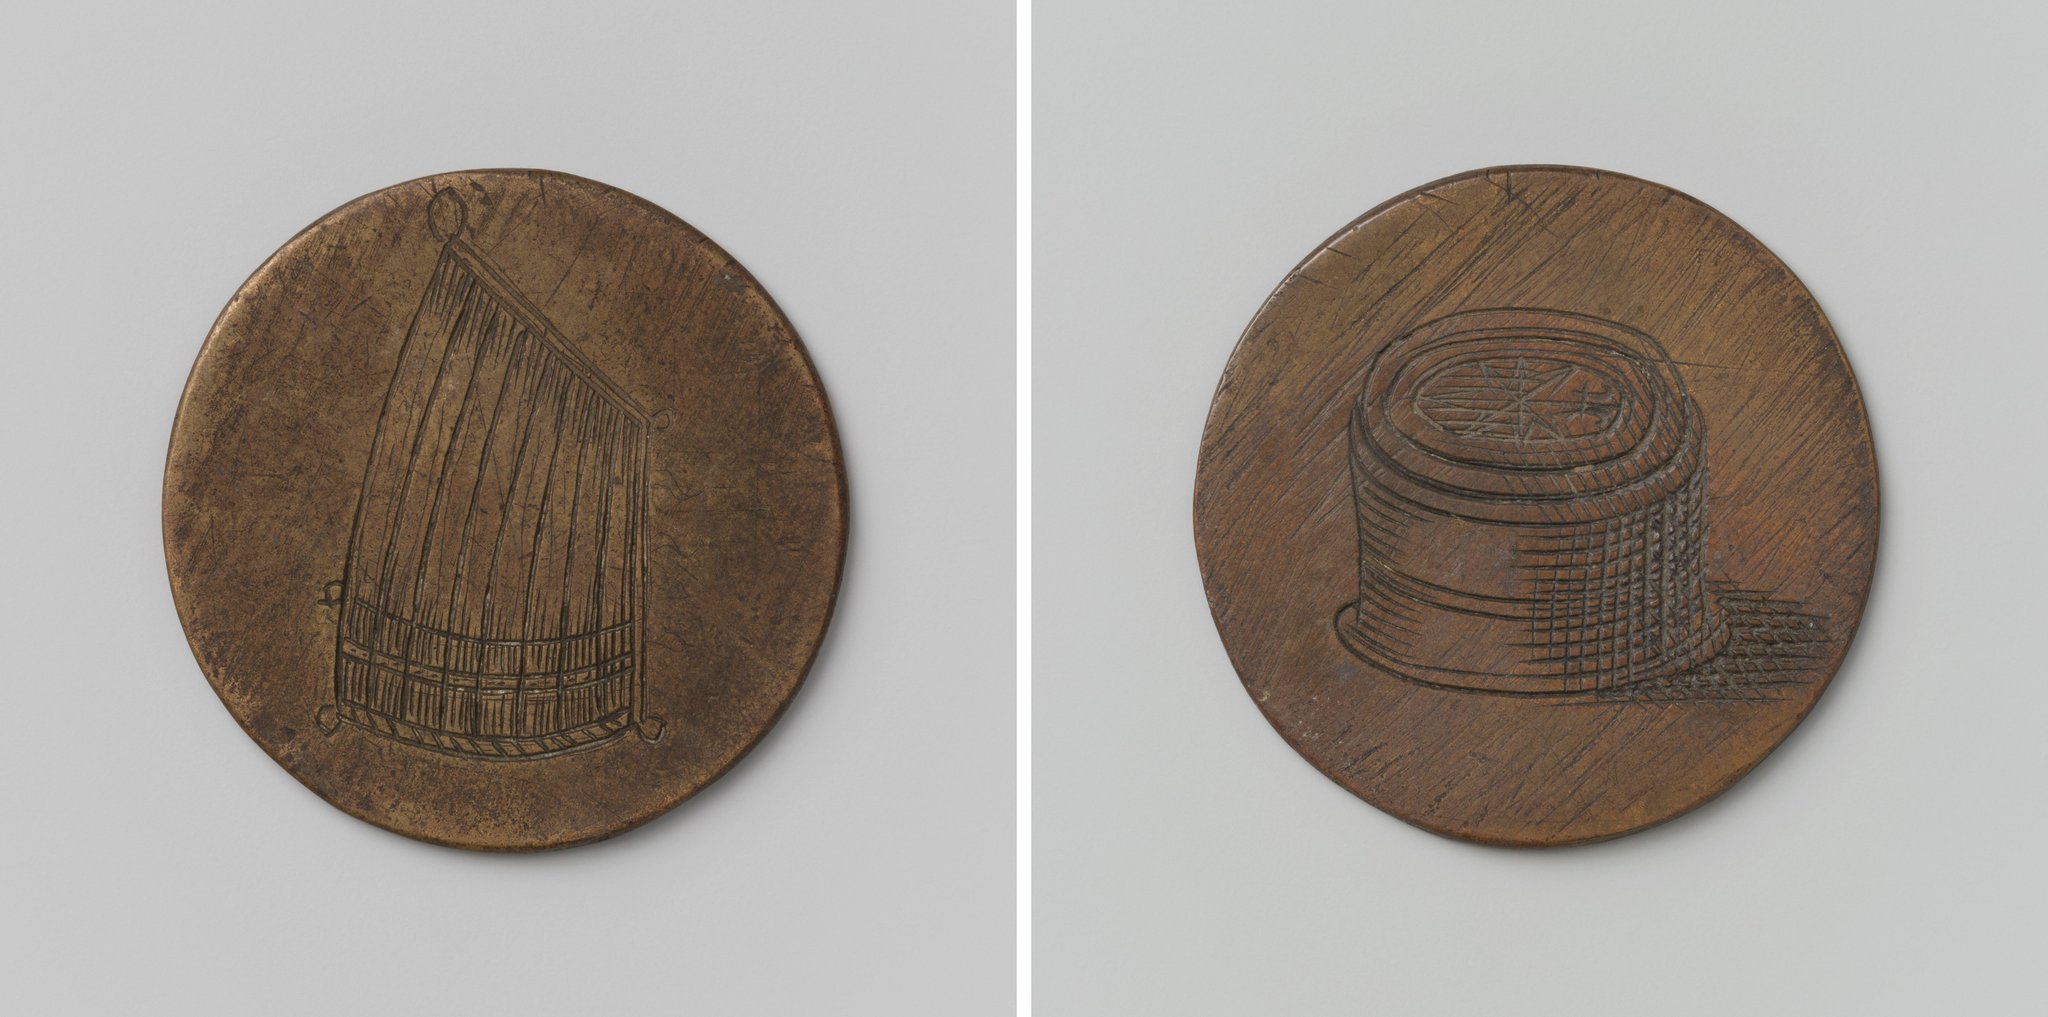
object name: medal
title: Kompas- en zeilmakersgilde van Amsterdam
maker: Anonymous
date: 1740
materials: brass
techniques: engraving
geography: amsterdam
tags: amsterdam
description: Messing penning, v.z:zeil. Keerzijde:kompas.